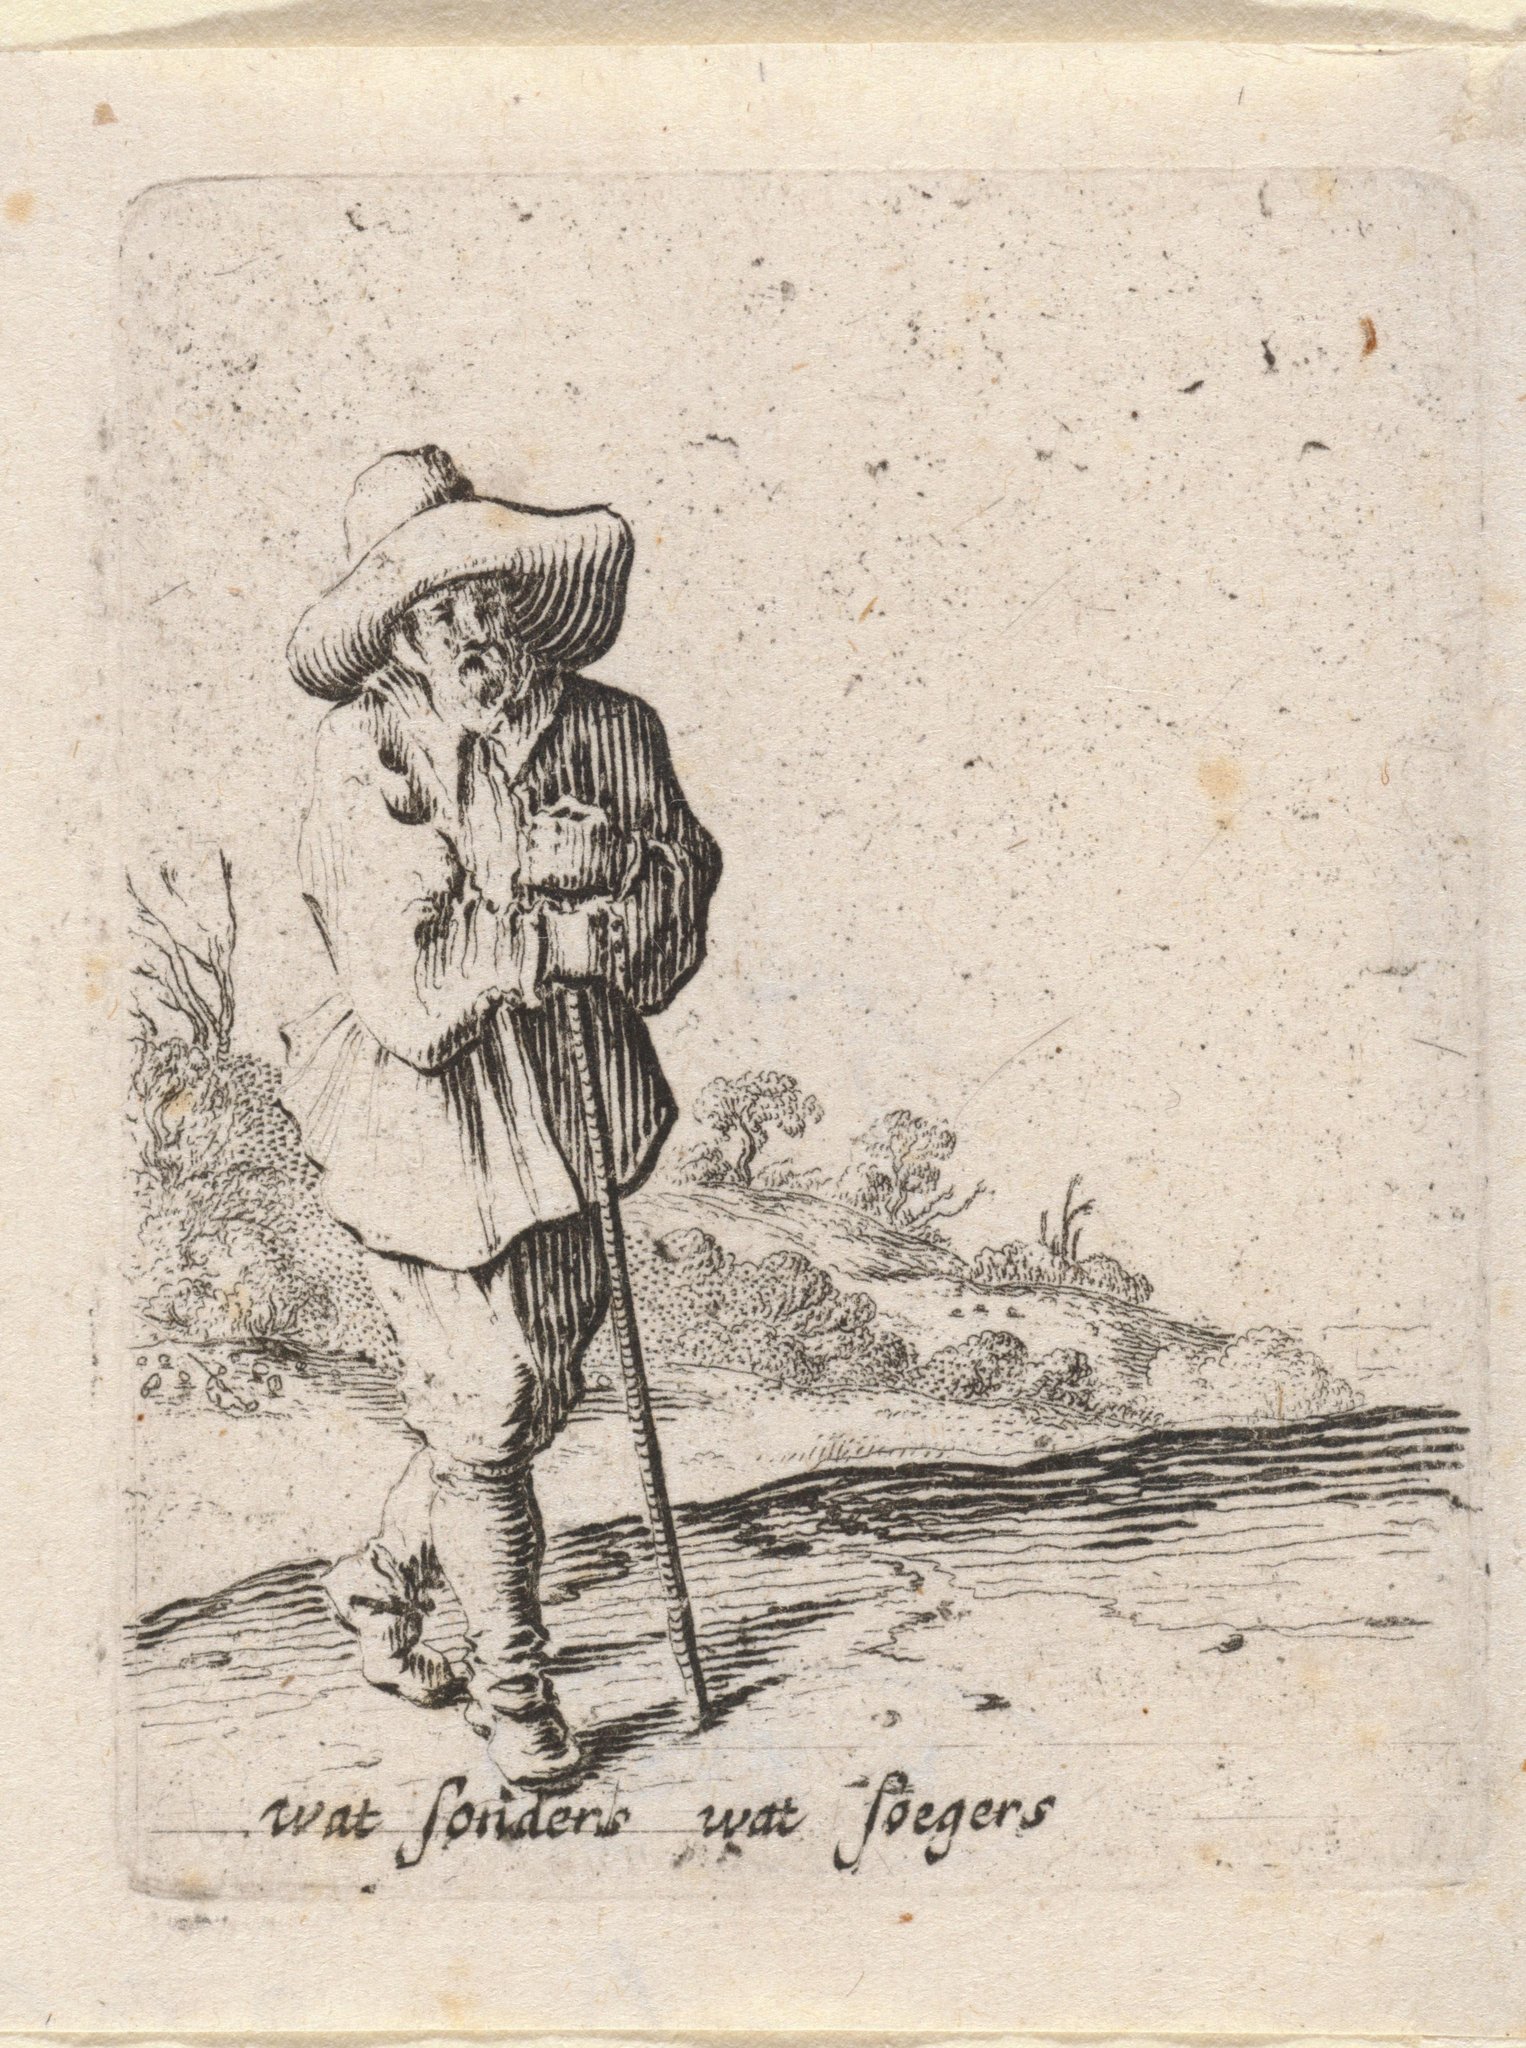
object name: print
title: Man leunend op een stok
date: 1638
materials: paper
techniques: etching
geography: amsterdam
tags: walking-stick, staff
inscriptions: collector's mark: Lugt 2228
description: Een man met op het hoofd een hoed met een brede rand, leunt op een wandelstok. Op de achtergrond een heuvel. De prent maakt deel uit van een serie van 32 prenten met genretaferelen.